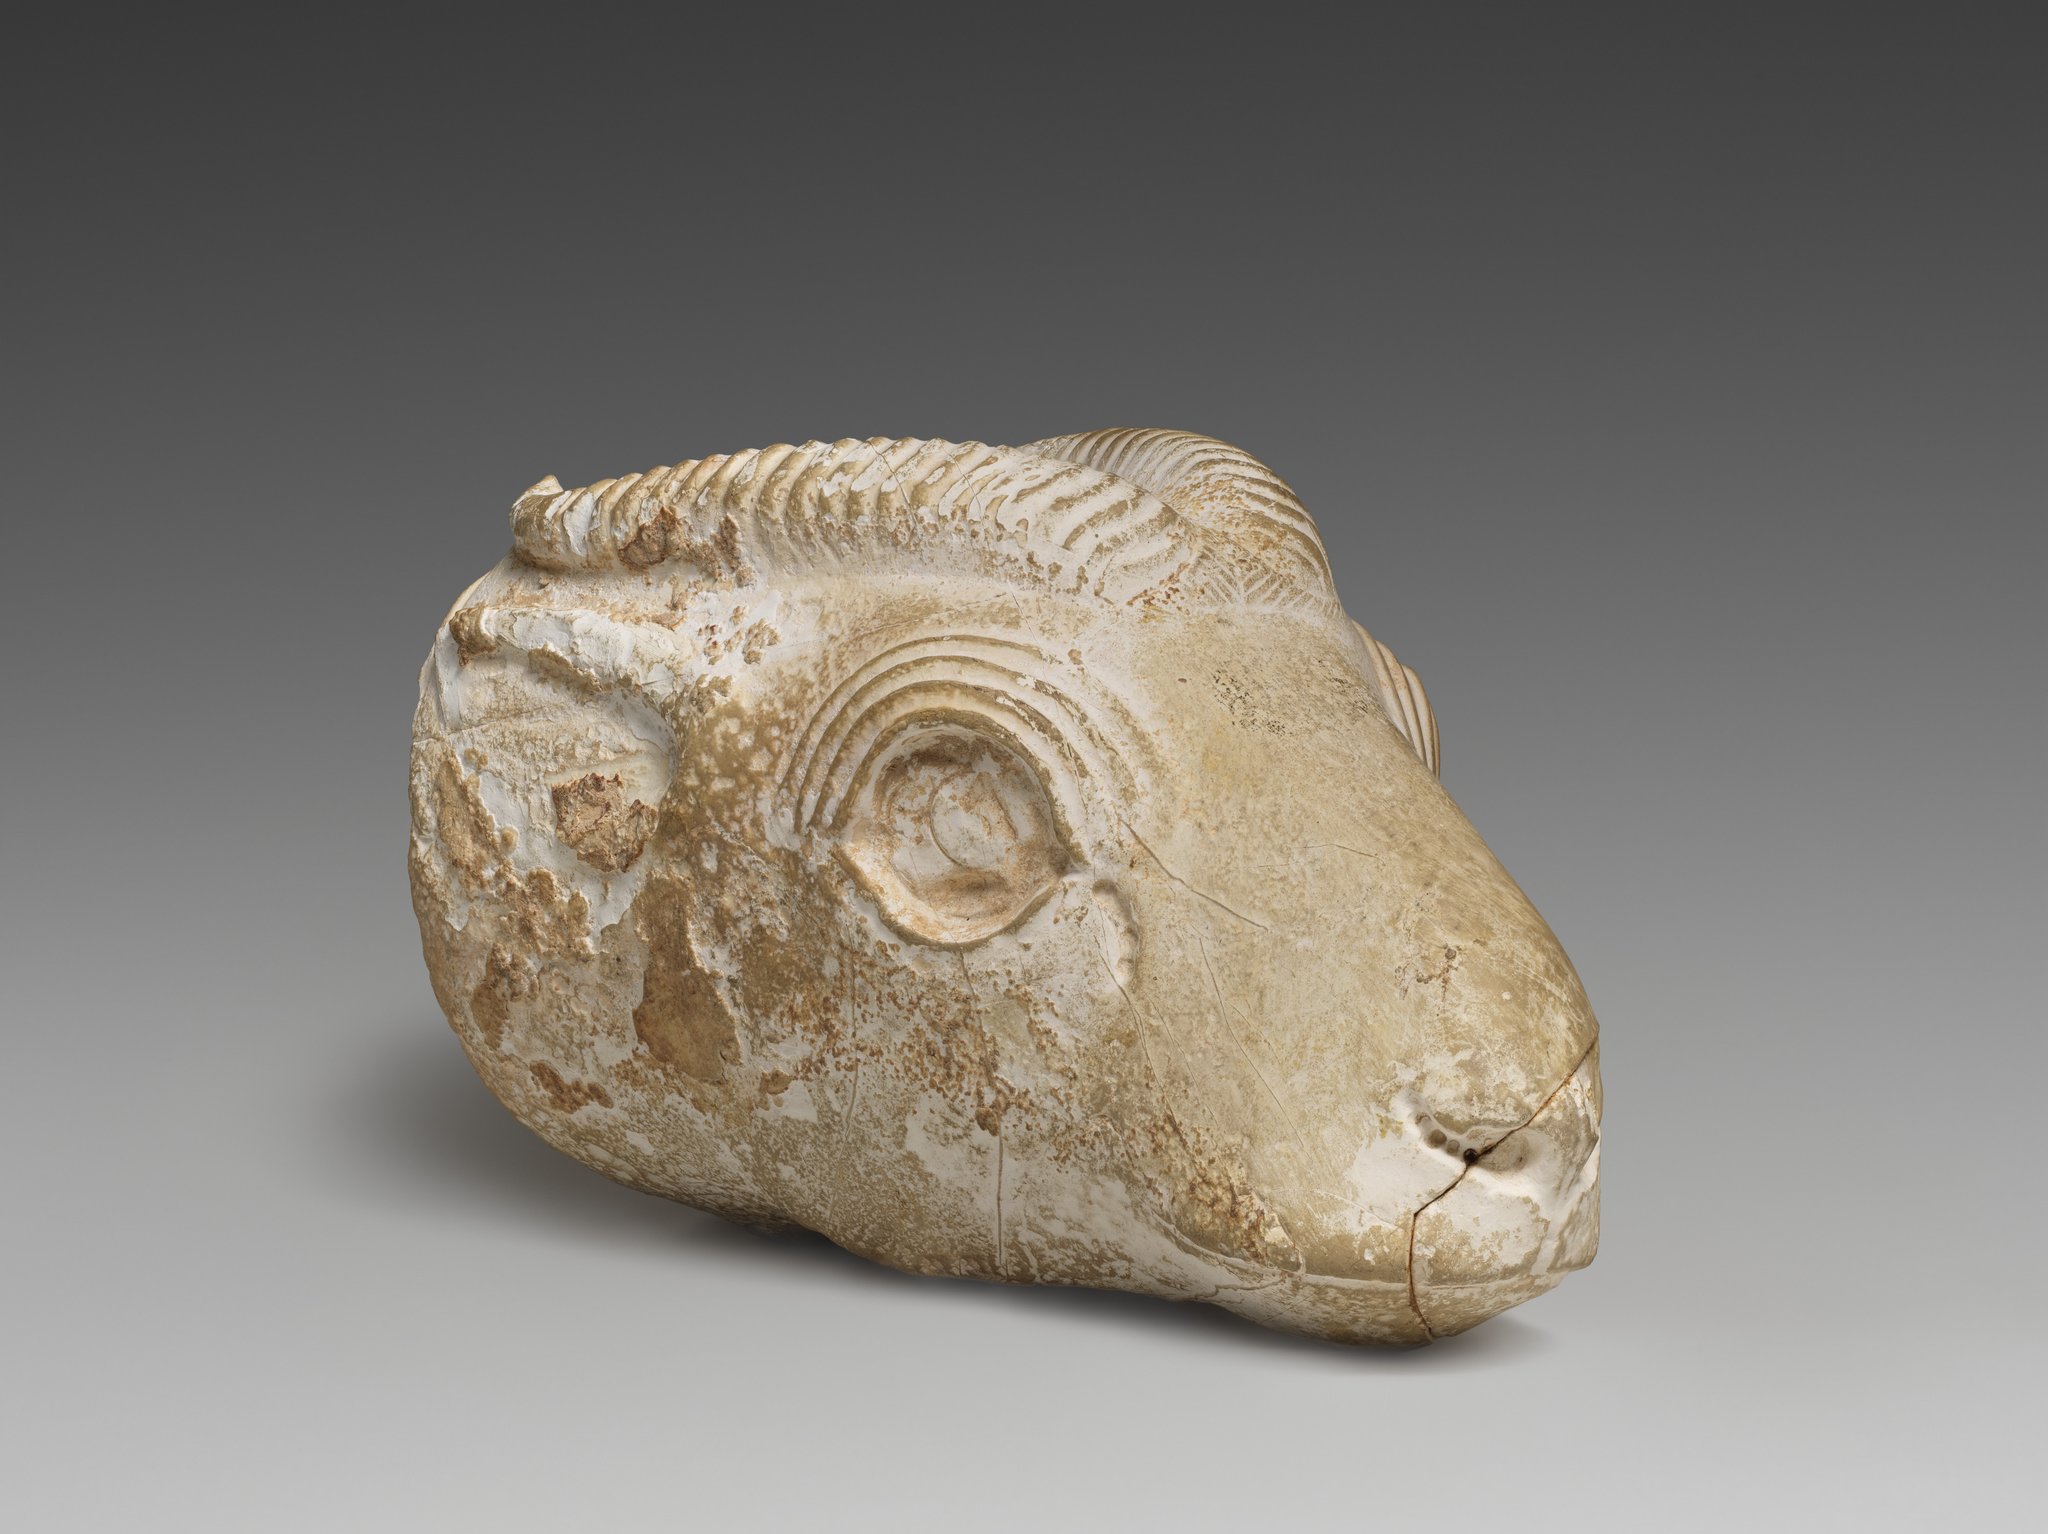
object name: cup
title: Drinking cup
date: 1000-1 BCE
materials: limestone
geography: iran or mesopotamia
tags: animals